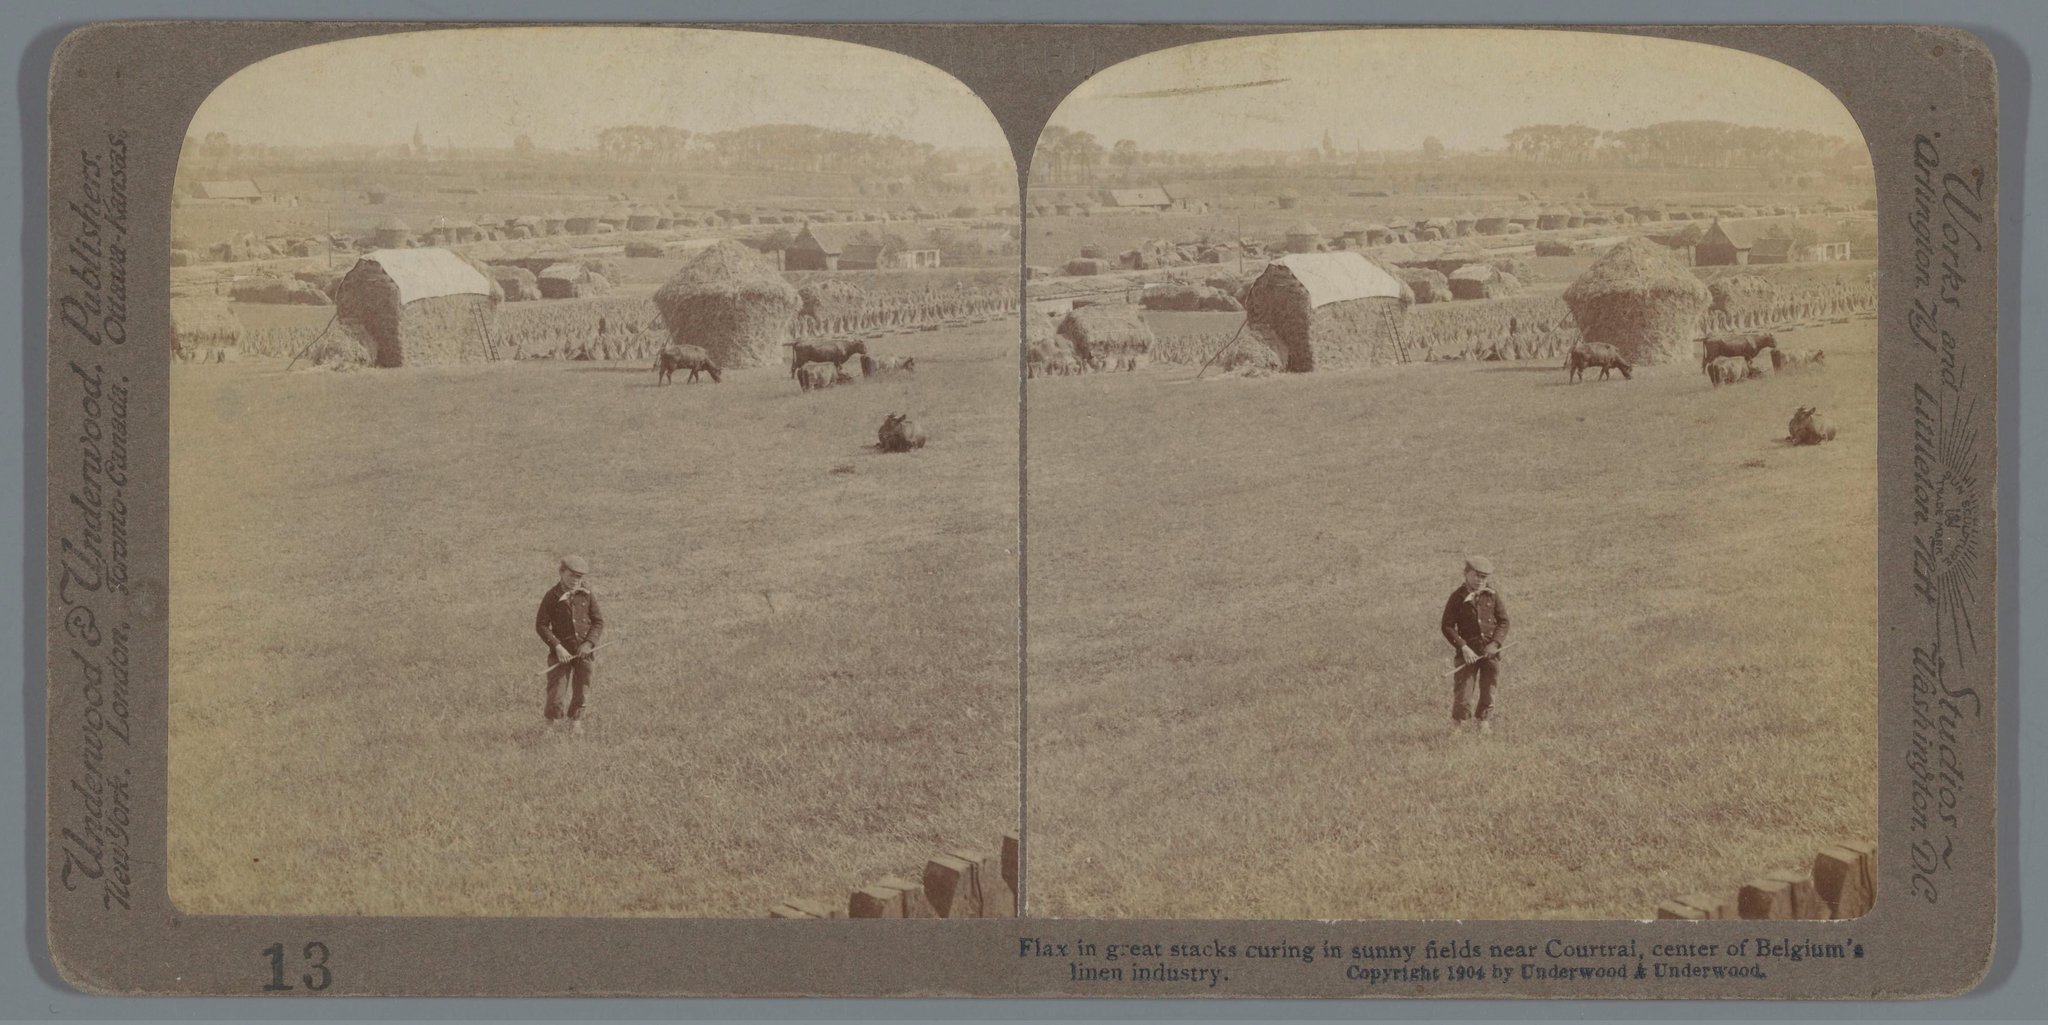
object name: stereograph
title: Flax in great stacks curing in sunny fields near Courtrai, center of Belgium's linen industry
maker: Anonymous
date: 1904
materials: cardboard, paper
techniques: albumen print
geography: kortrijk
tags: flax (material ~ textile industry), stocking (on the field)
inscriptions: inscription: ‘(EMERET)’, inscription: ‘Works and Studios ~/ Arlington, N.J. Littleton, N.H. Washington, D.C.’, copyright notice: ‘Copyright 1904 by Underwood & Underwood.’, number: ‘13’, inscription: ‘C 13.’